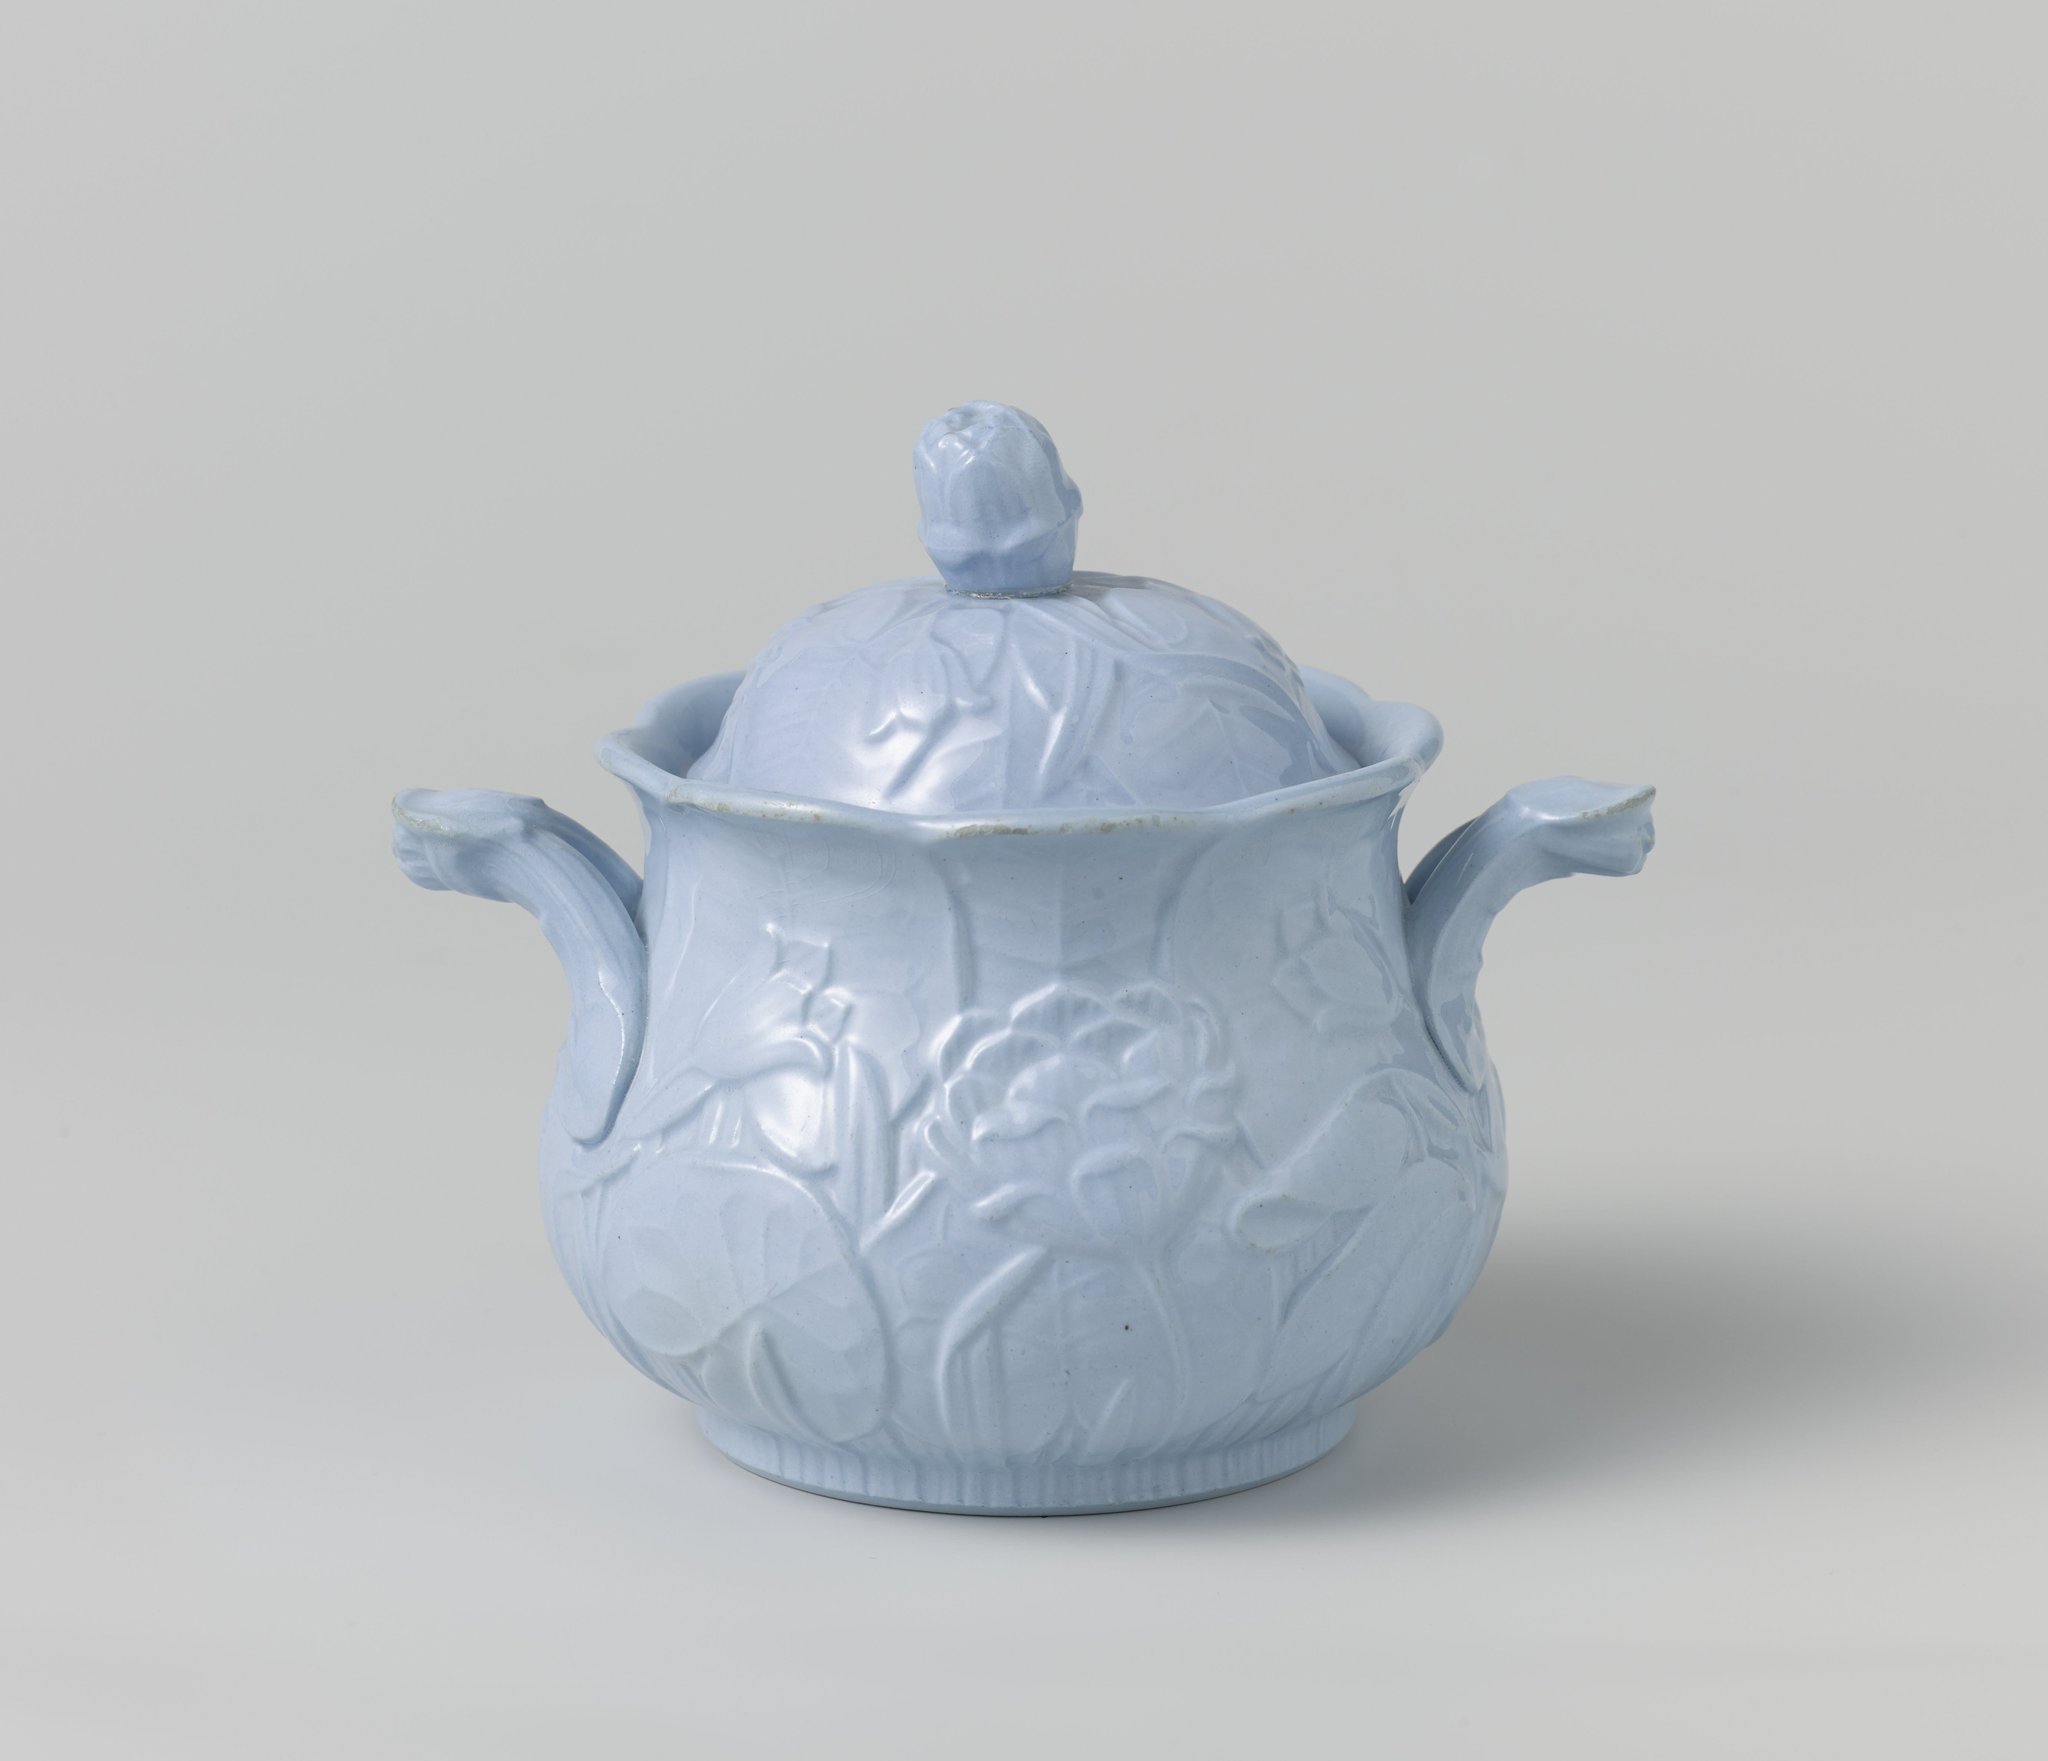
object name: sugar box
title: Suikerpot met deksel, blauw, met bladeren en bloemen in reliëf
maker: petrus regout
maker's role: plateelbakker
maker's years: 1801-1879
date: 1801-1879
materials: earthenware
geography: maastricht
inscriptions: check stamp: ‘P. REGOUT // MAASTRICHT // 00’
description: Suikerpot met deksel van blauwsteen, met in reliëf bladeren en bloemen over het gehele oppervlak. De bovenrand van de pot is geschulpt. Het gewelfde deksel, met bladeren en bloemen in reliëf, wordt bekroond door een bloemknop.